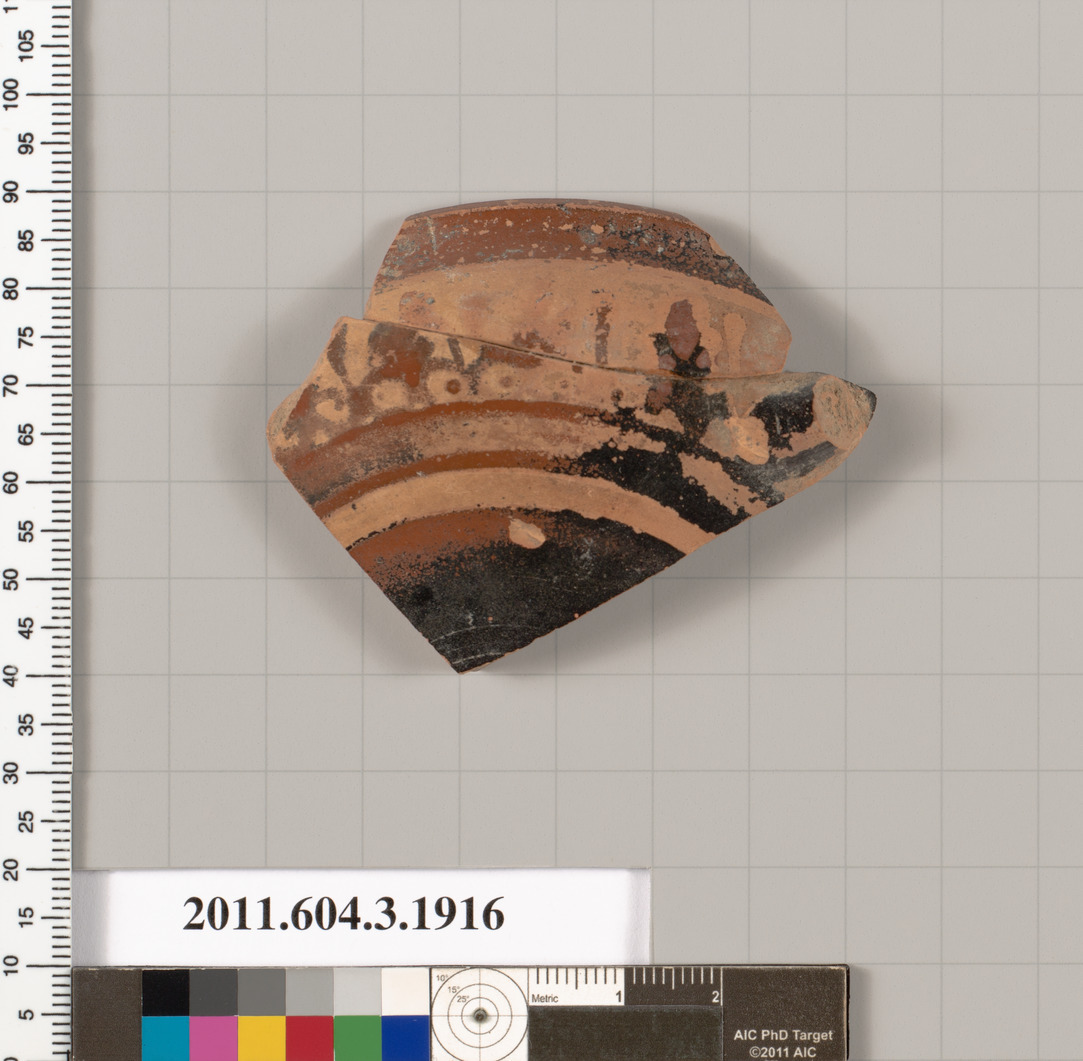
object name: kylix or skyphos fragment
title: Terracotta fragment of a kylix (drinking cup) or a skyphos (deep drinking cup)?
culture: greek, attic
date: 534-468 BCE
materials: terracotta